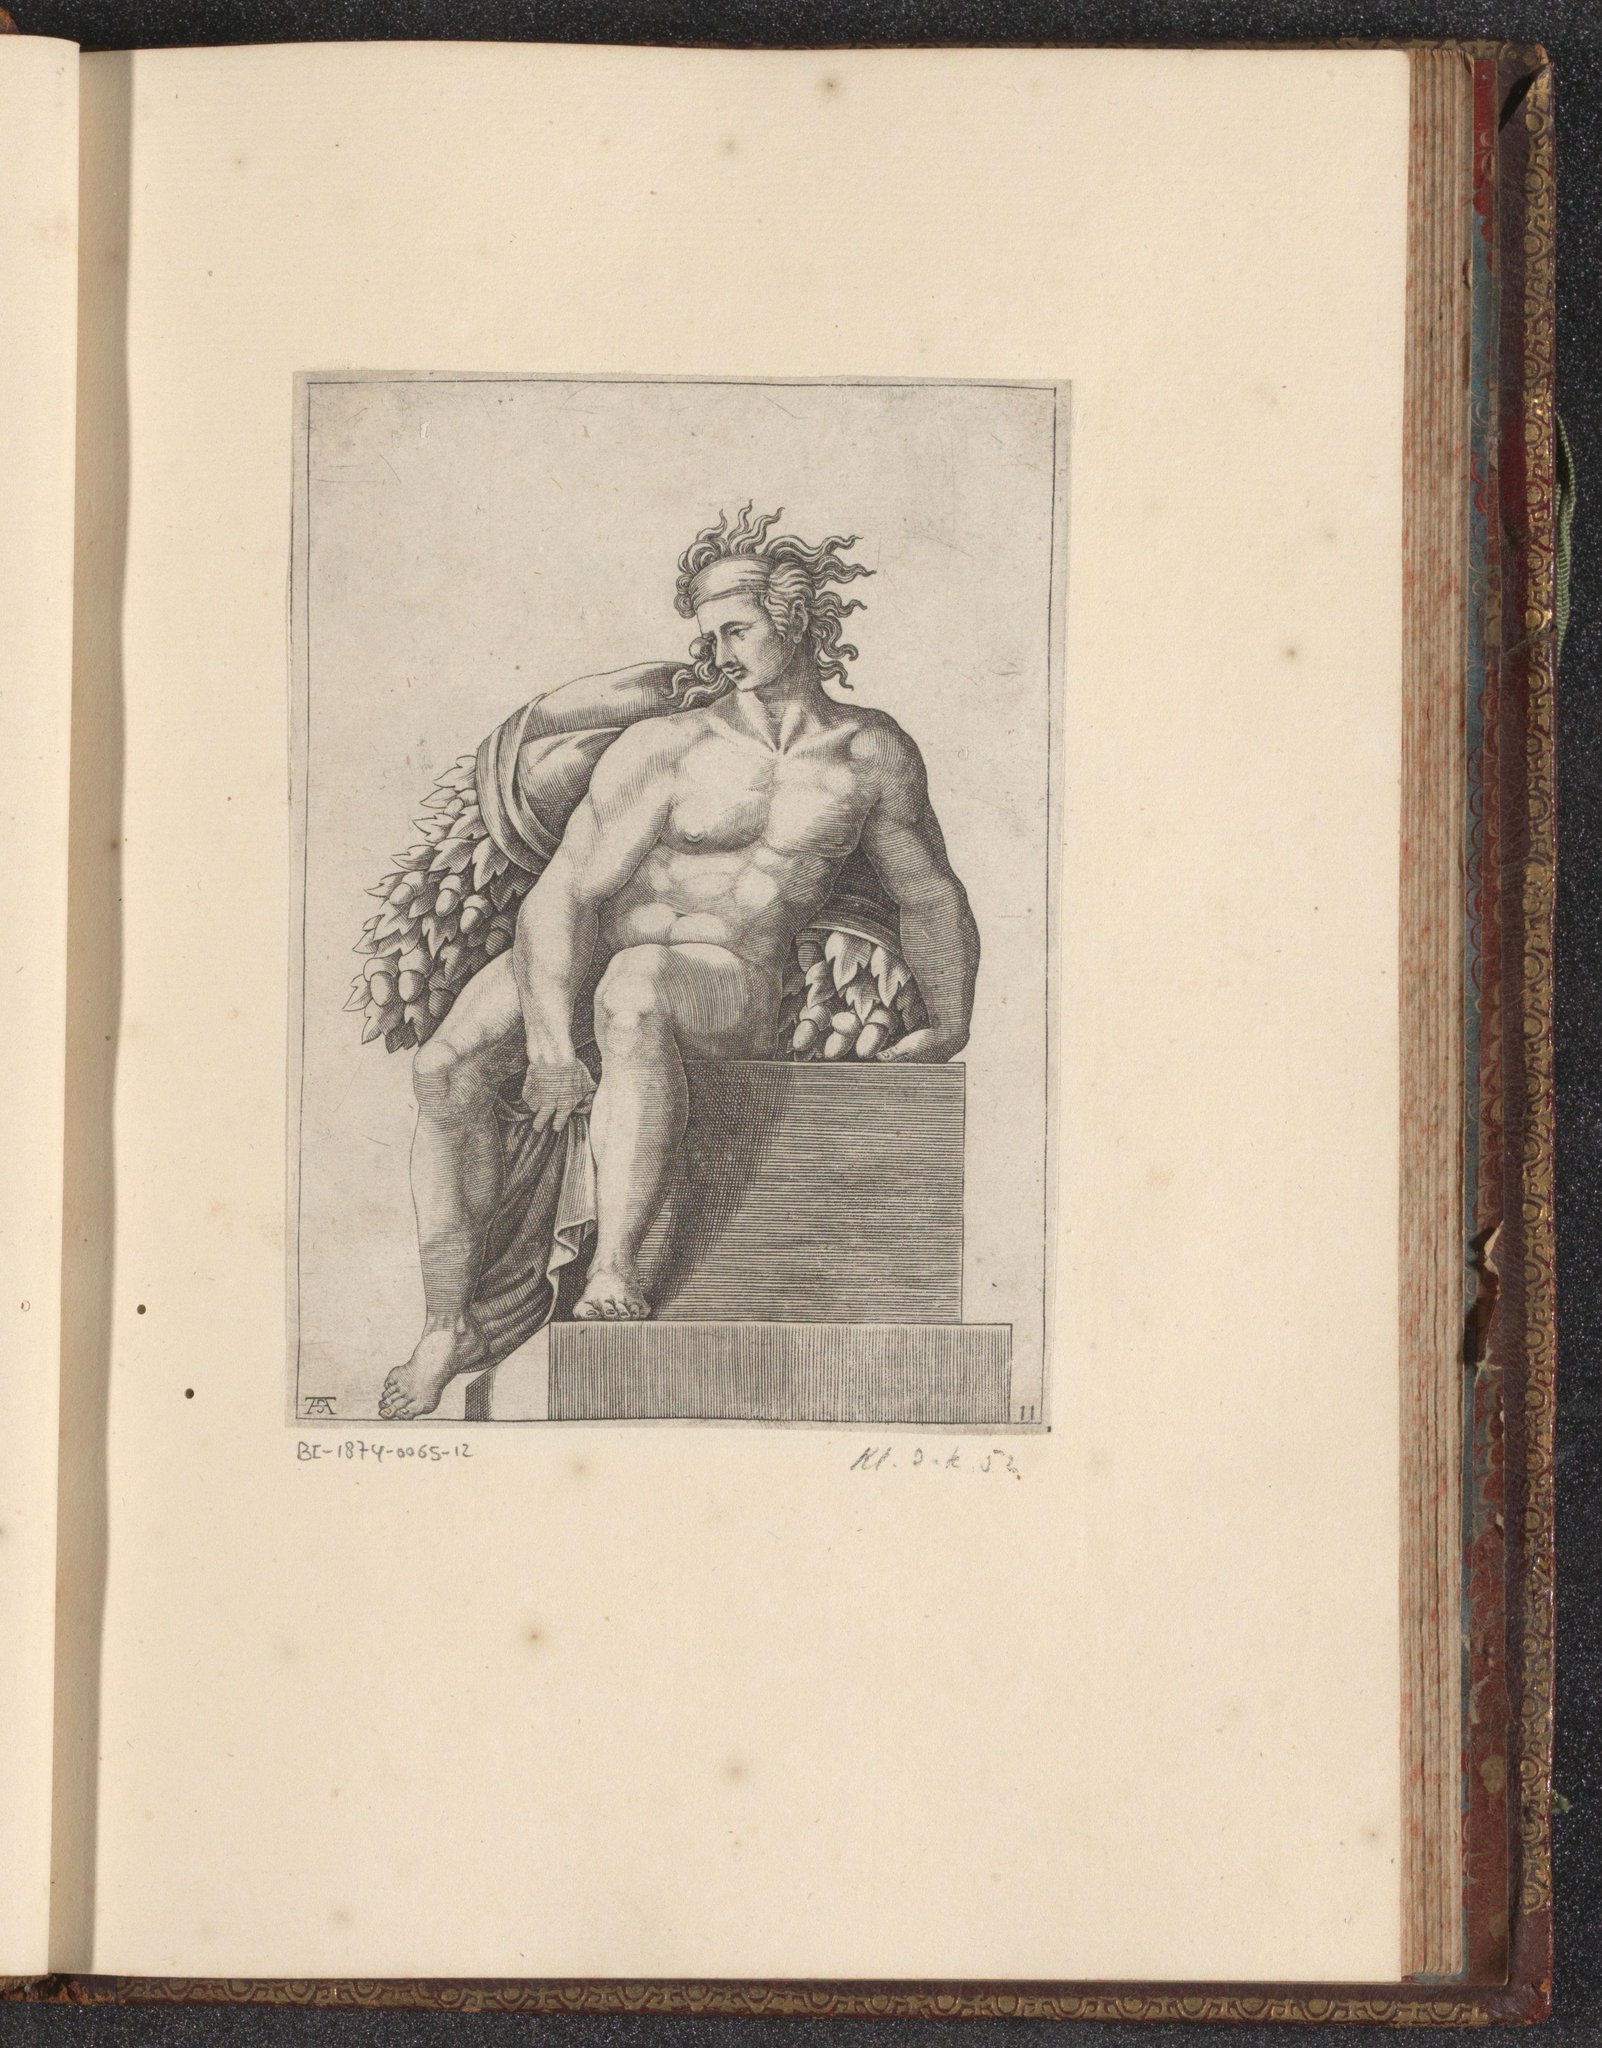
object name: print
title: Zittend naakt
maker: adamo scultori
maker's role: painter, print maker, sculptor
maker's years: 1530-1585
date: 1585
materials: paper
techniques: engraving, intaglio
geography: vatican city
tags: the (nude) human figure; 'corpo humano' (ripa), fruits: acorn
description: Zittende naakte man, gedeeltelijk naar links gedraaid, met een guirlande van eikels. Eén van de 'ignudi' (naakte mannen) van Michelangelo's plafondschildering. Genummerd rechtsonder: 11. De prent maakt deel uit van een album.